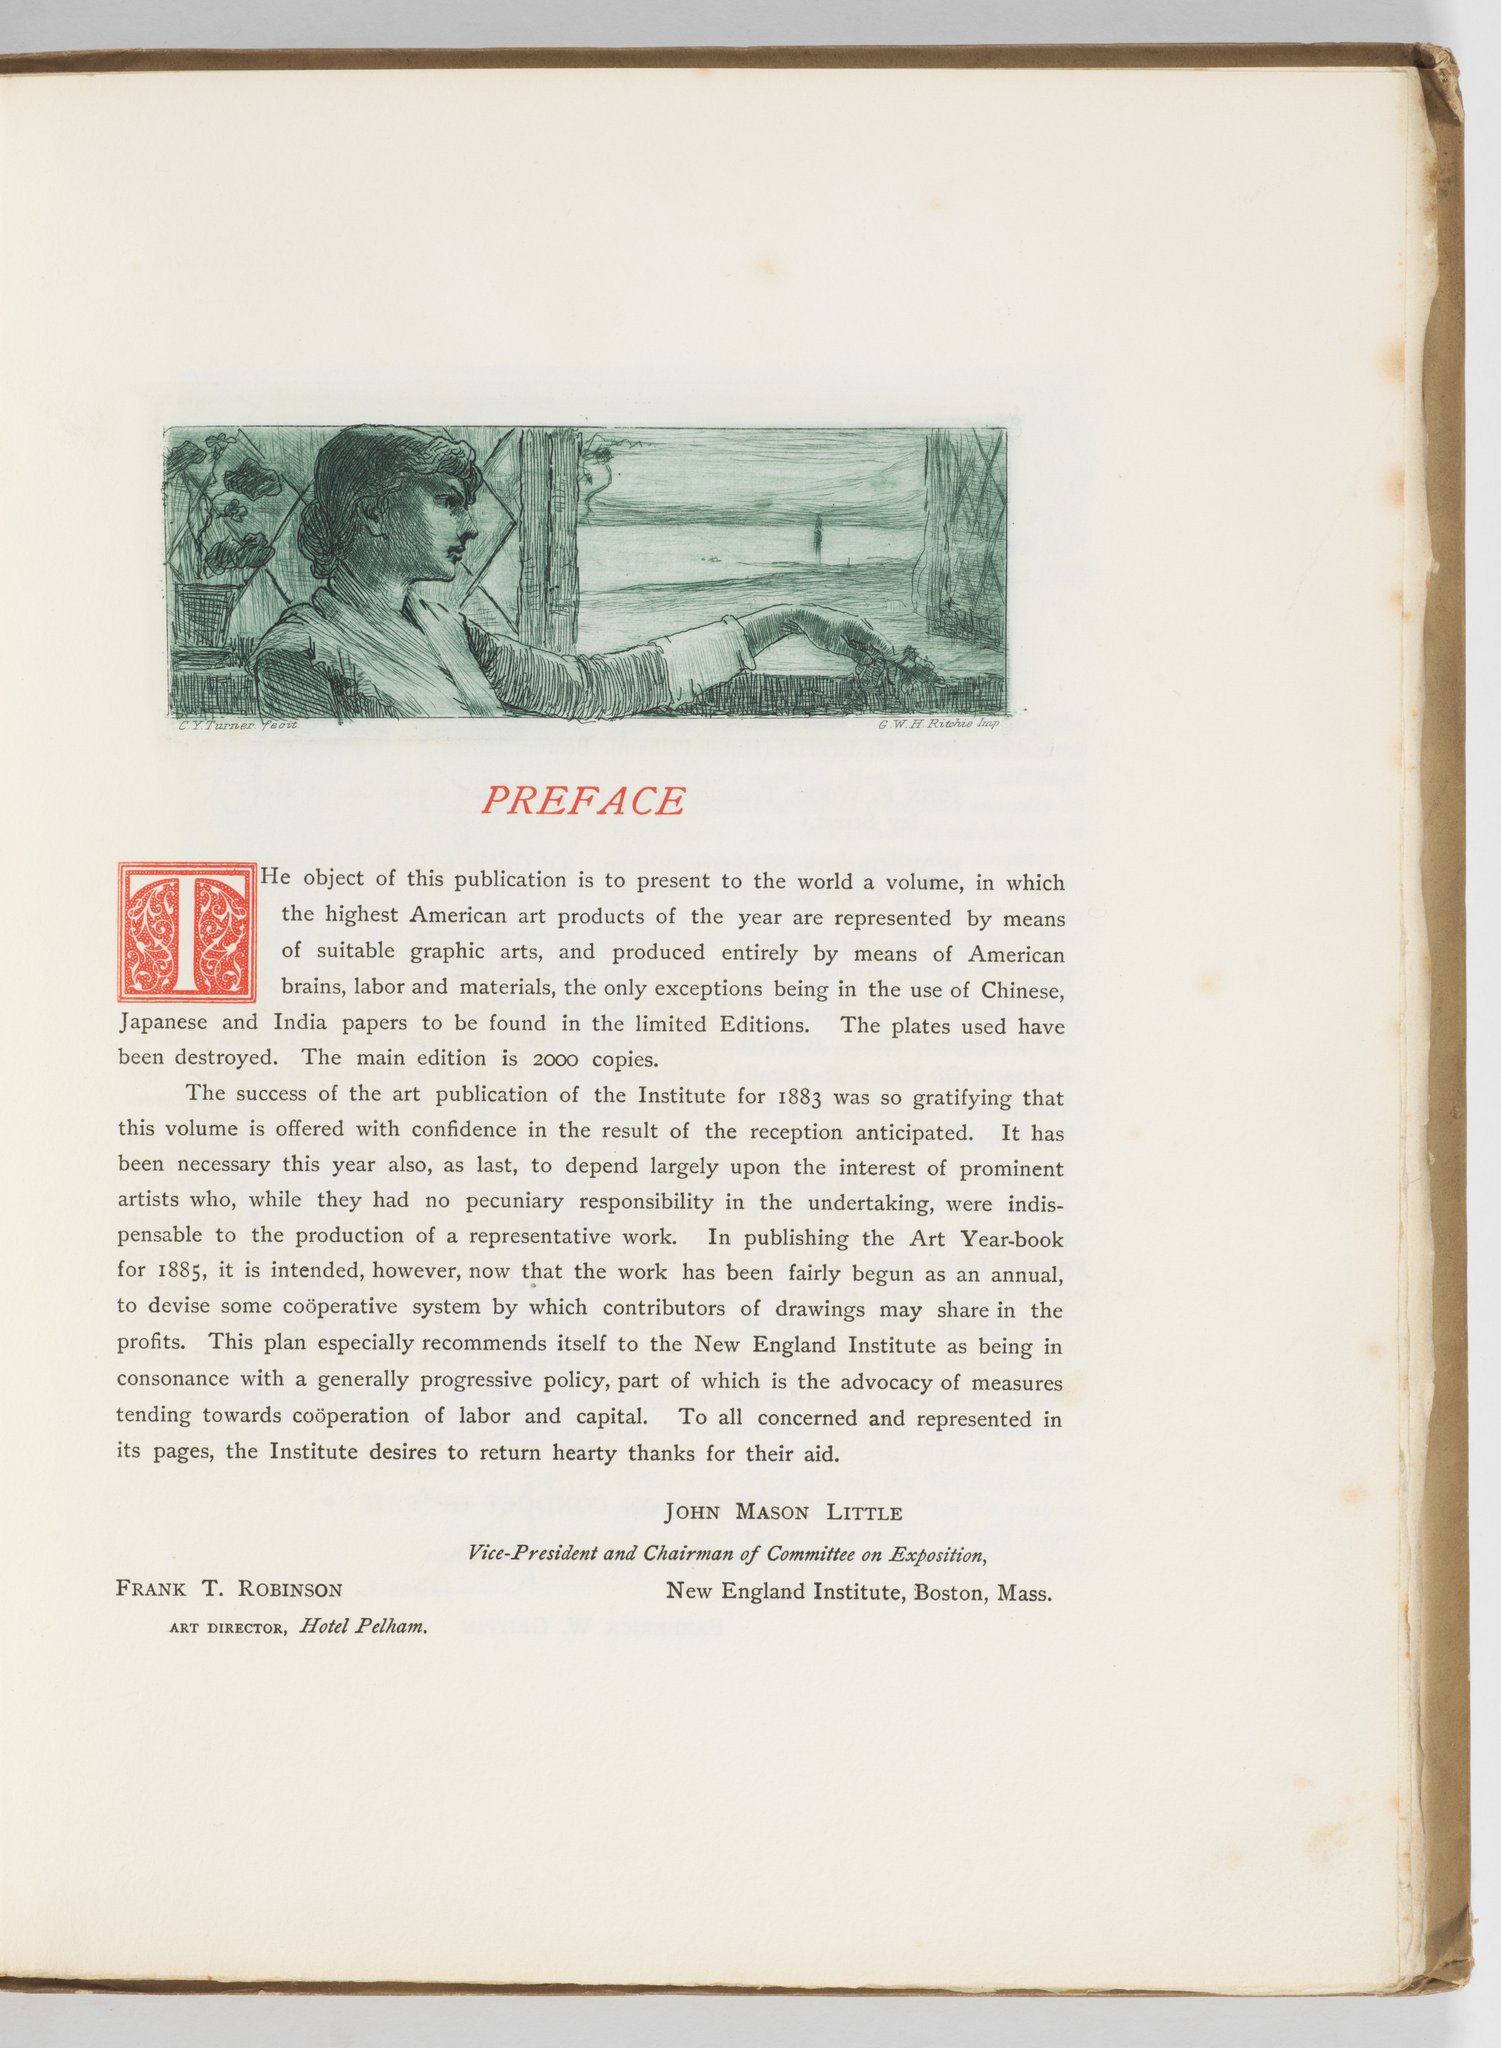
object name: book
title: Art Year Book 1884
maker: new england institute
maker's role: author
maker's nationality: american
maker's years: 1850-1900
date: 1884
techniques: etching, lithograph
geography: boston